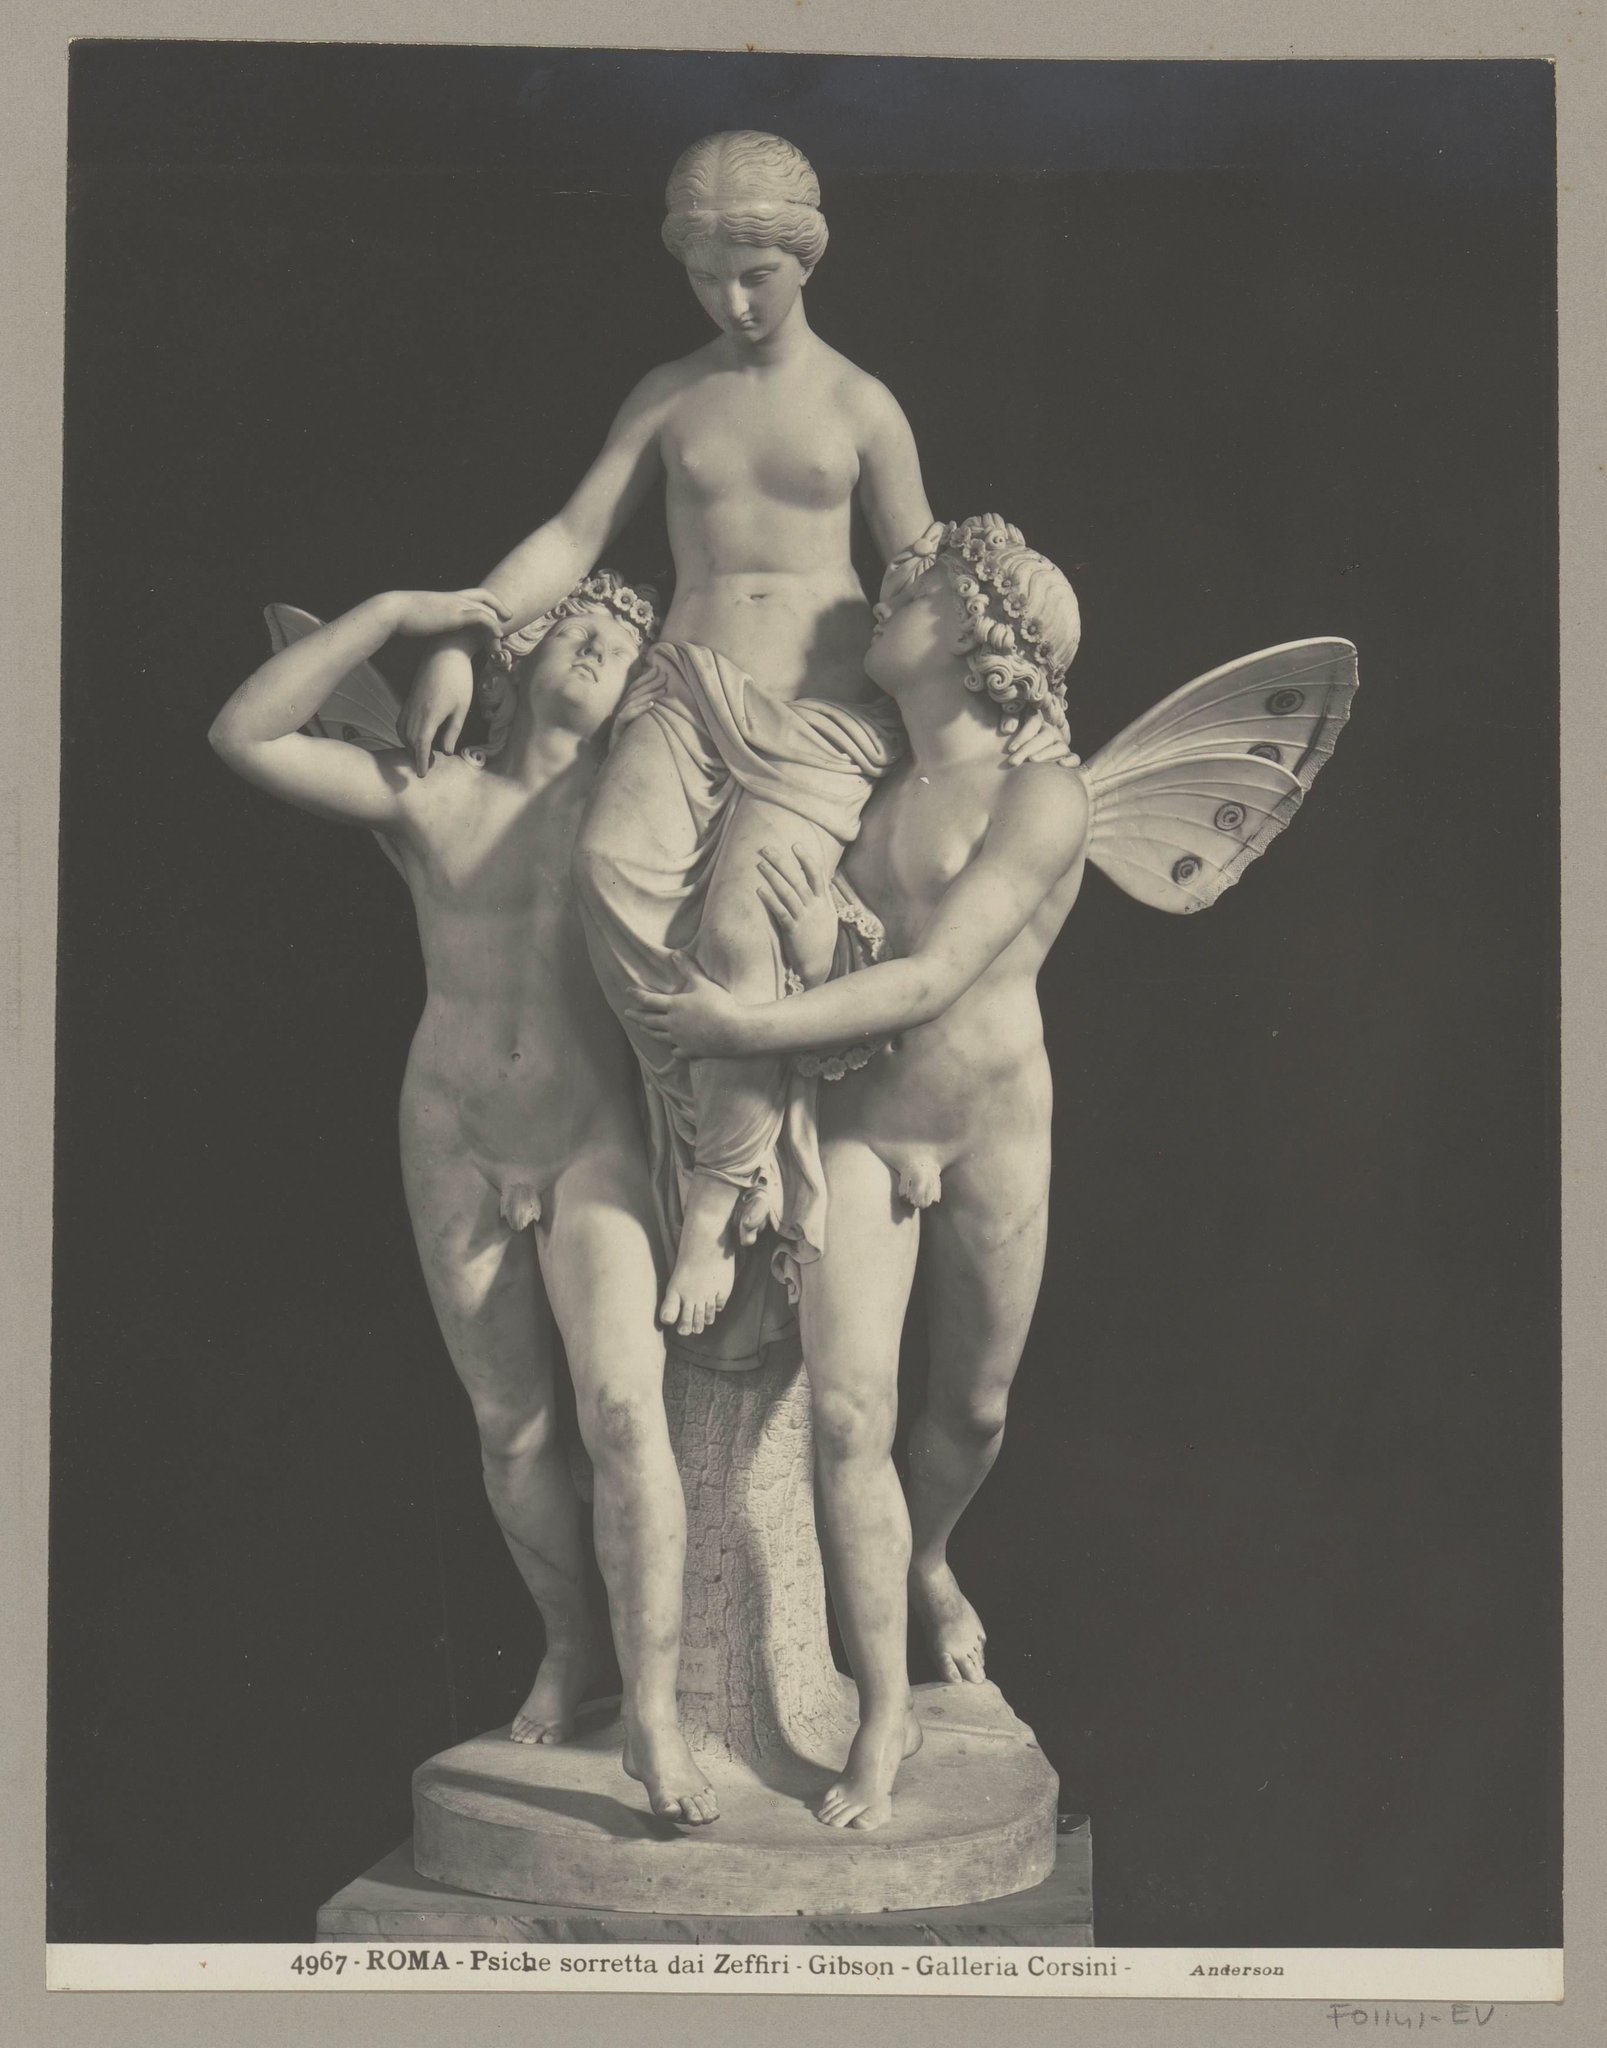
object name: photograph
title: ROMA - Psiche sorretta dai Zeffiri - Gibson - Galleria Corsini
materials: photographic support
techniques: gelatin silver print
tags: love-affairs of zephyrus, psyche (+ love-affairs), piece of sculpture, reproduction of a piece of sculpture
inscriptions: number: ‘4967’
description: Onderdeel van Fotoalbum van een reis door Zuid-Europa en het Midden-Oosten.